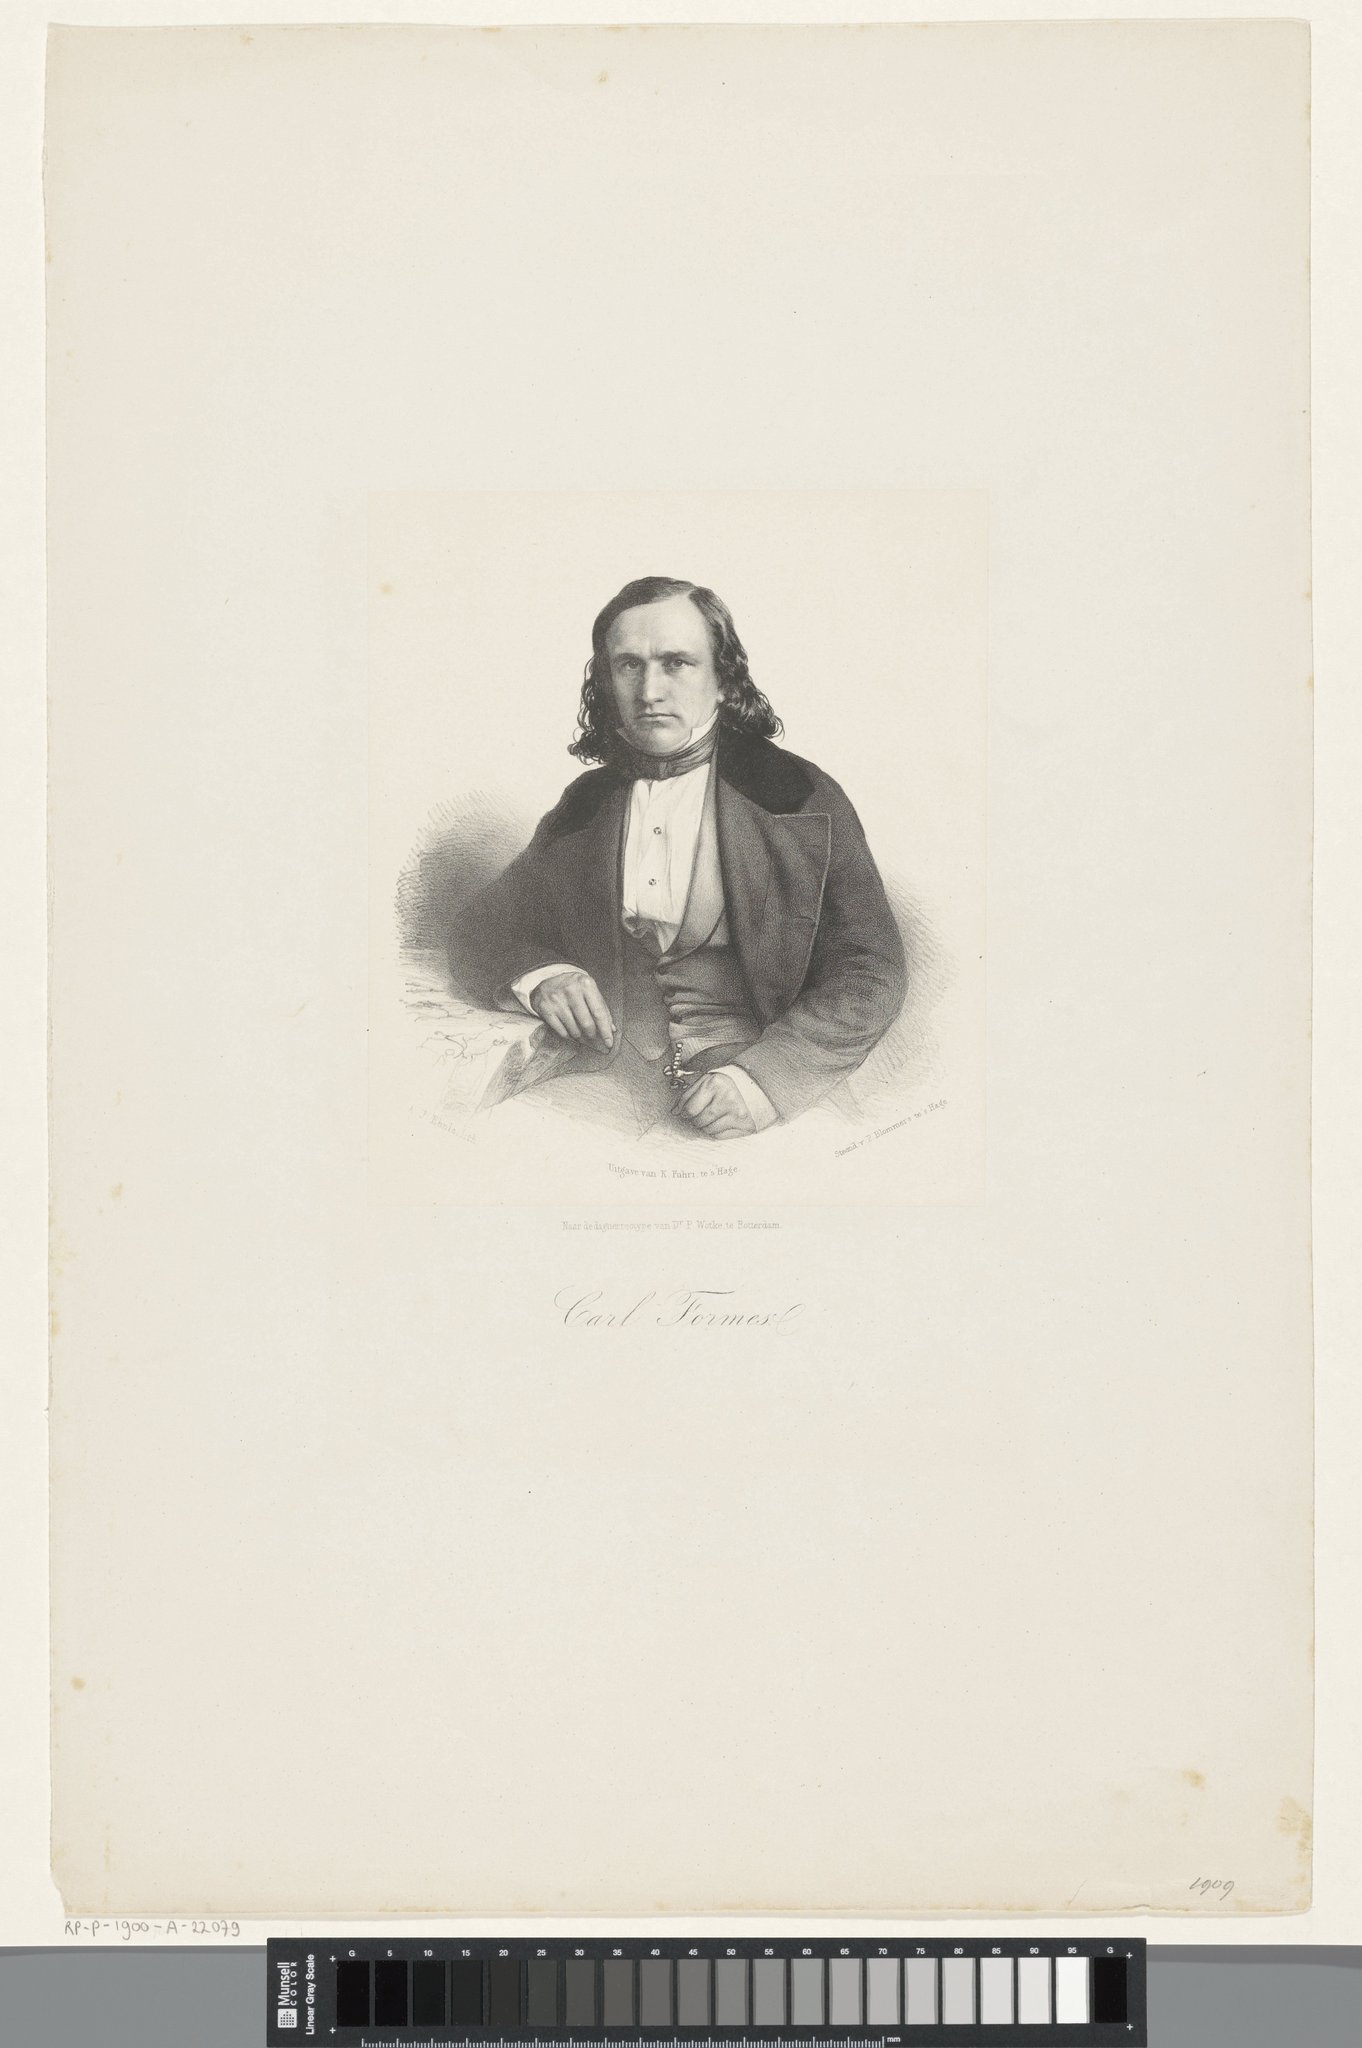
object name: print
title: De Maatschappij ter Bevordering van Toonkunst, haar Muziekfeest en de stad Rotterdam. herinnering aan het jaar 1854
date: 1855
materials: paper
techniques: lithograph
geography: haarlem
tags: historical persons (+ (full) bust portrait)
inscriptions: collector's mark: Lugt 2228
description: De geportretteerde zit aan een tafel, onder het portret zijn naam. Onderdeel van een serie van twaalf portretten naar daguerrotypieën en twaalf stadsgezichten. Ter gelegenheid van het Muziekfeest ter viering van het 25-jarige bestaan van de Maatschappij ter Bevordering van Toonkunst in Rotterdam, 12-15 juli 1854.